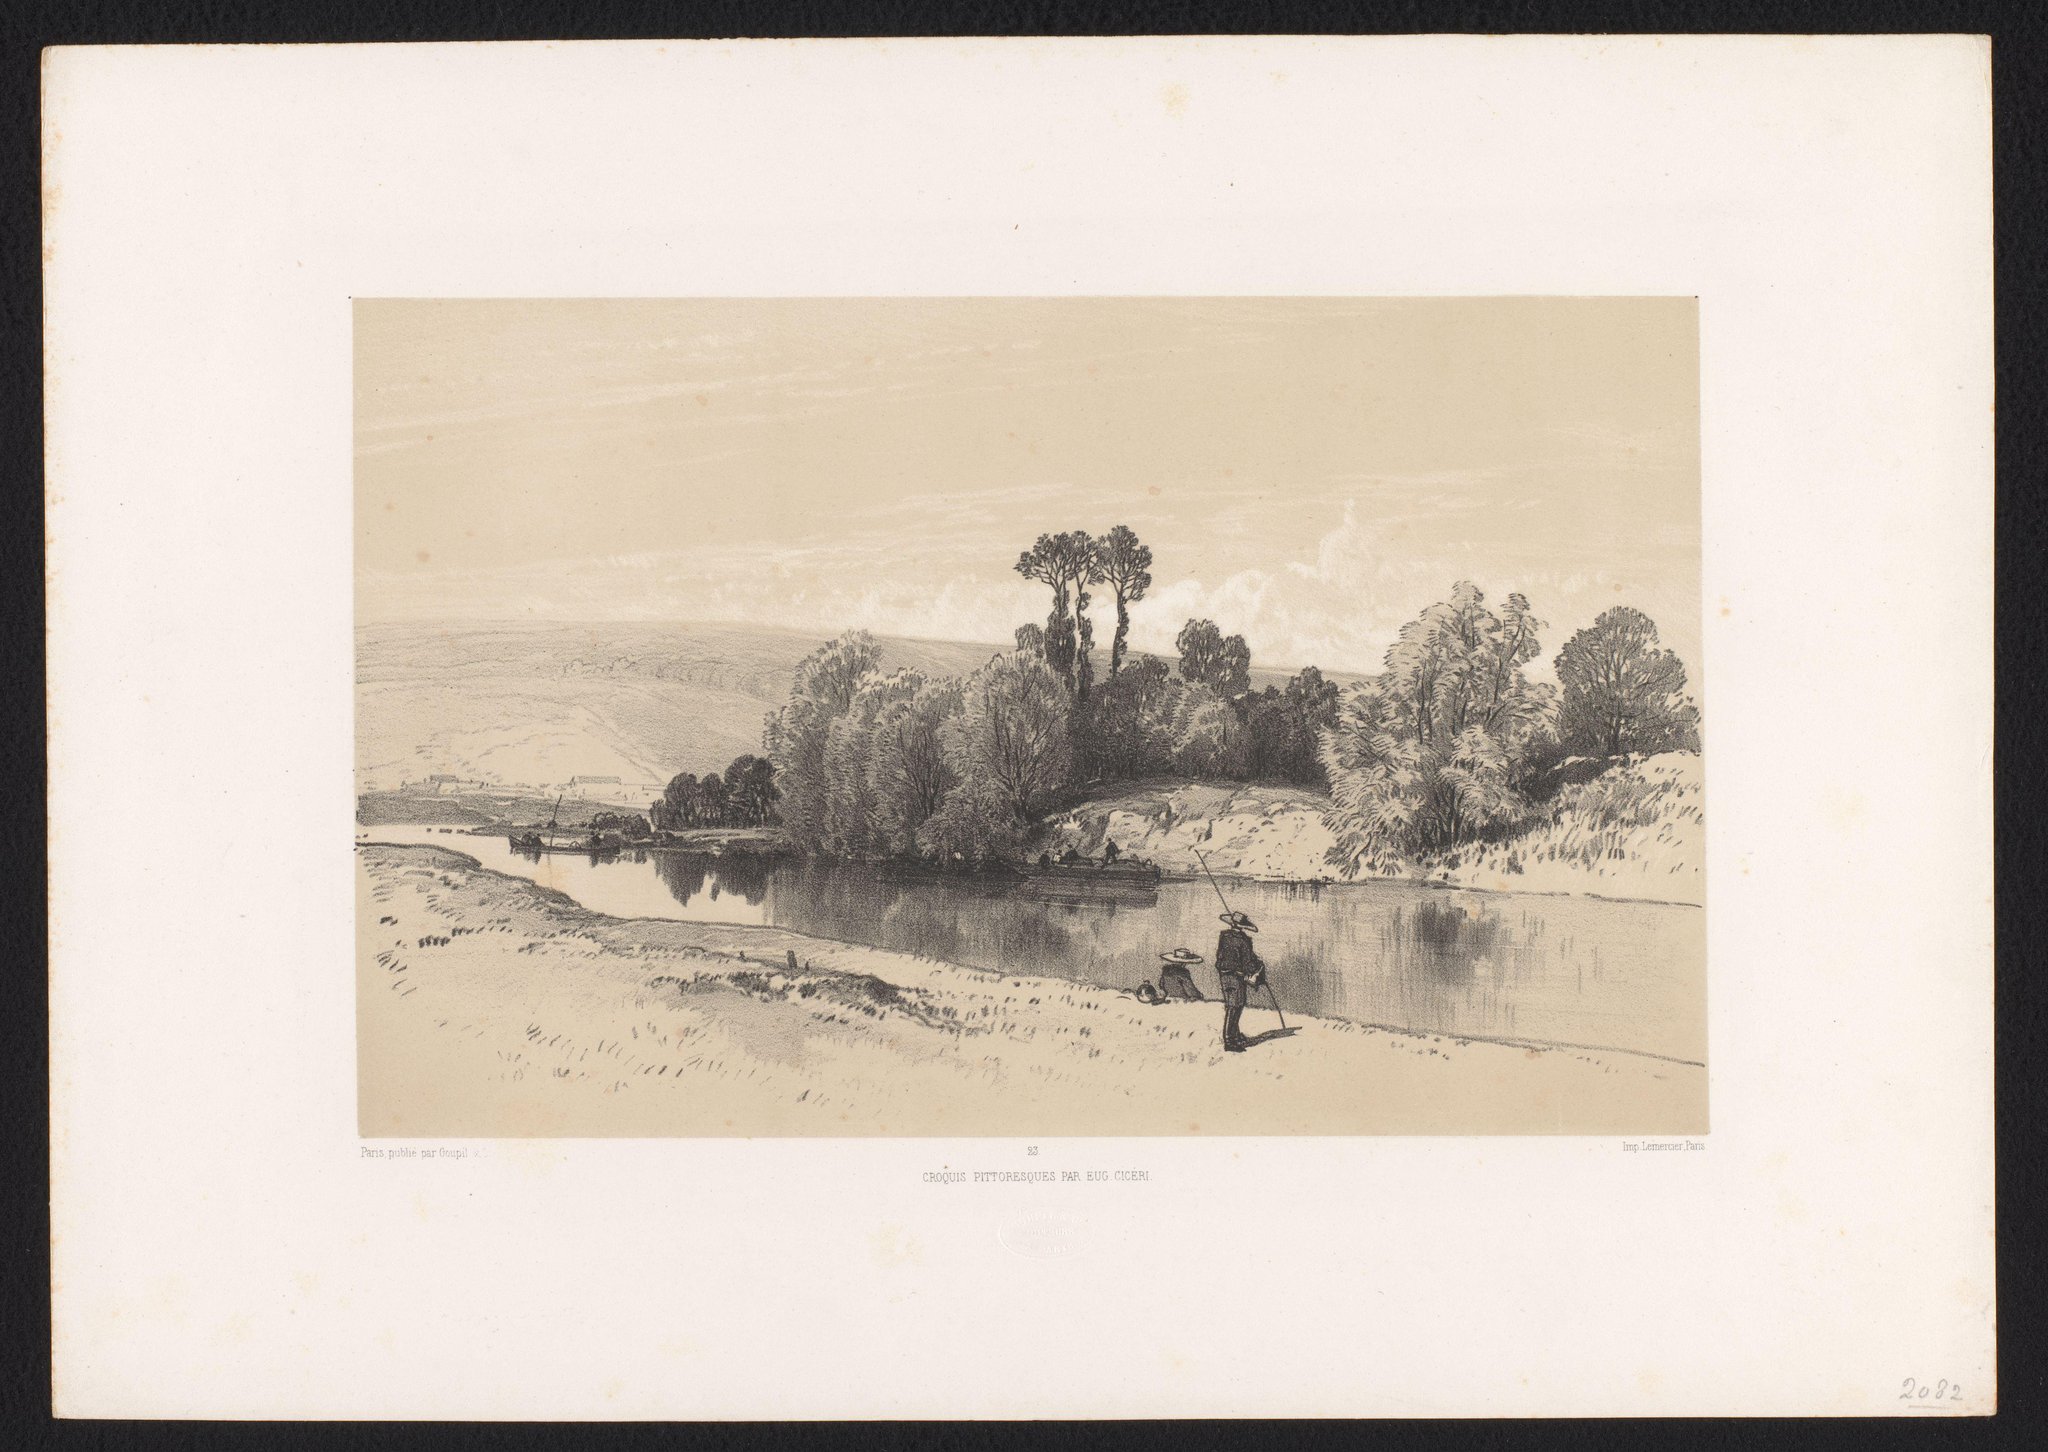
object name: print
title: Rivierlandschap met vissers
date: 1854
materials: paper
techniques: tone lithography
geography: paris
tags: commercial fishery, low hill country (+ landscape with figures, staffage), river (+ landscape with figures, staffage)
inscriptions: check stamp: Lugt 1090, number: ‘2082’